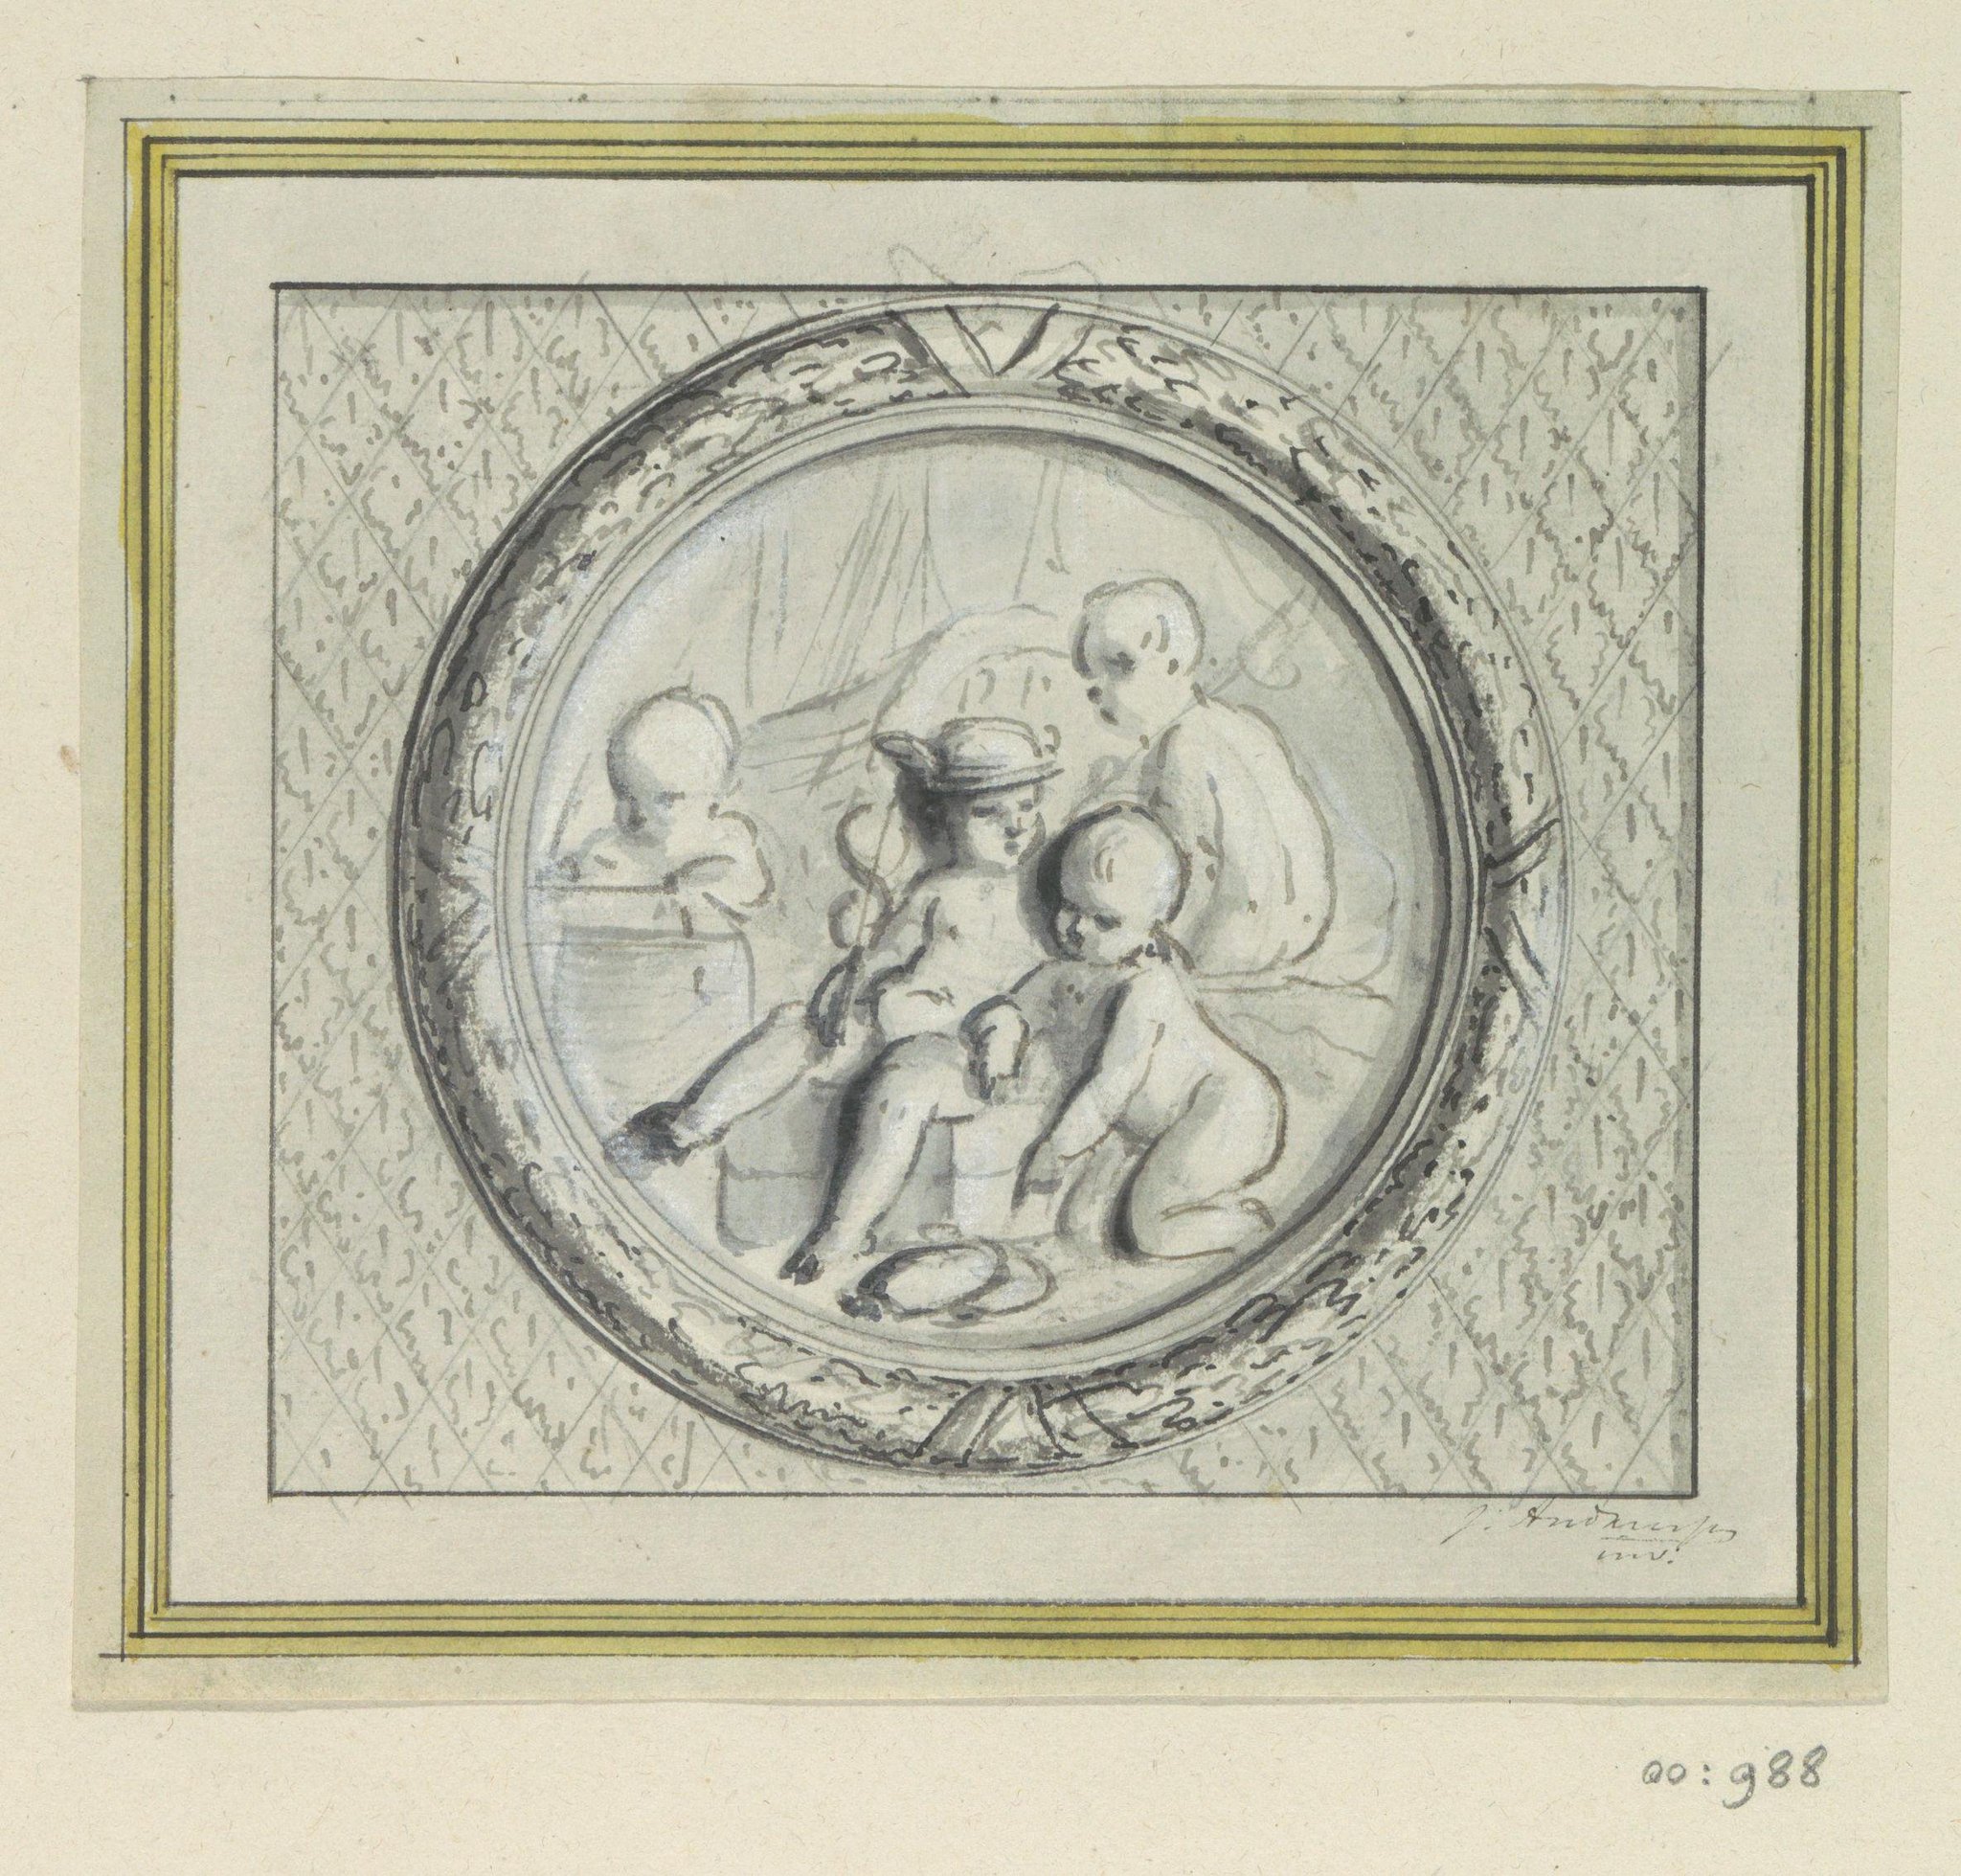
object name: album leaf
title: Vier putti waarvan één met de attributen van Mercurius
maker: jurriaan andriessen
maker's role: draughtsman, painter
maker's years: 1742-1819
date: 1760-1819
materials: paint, paper, pencil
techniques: brush, pen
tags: attributes of mercury, wall-covering, cupids: 'amores', 'amoretti', 'putti'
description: Mogelijk een ontwerptekening voor een kamerdecoratie. Tekening maakt deel uit van een album.